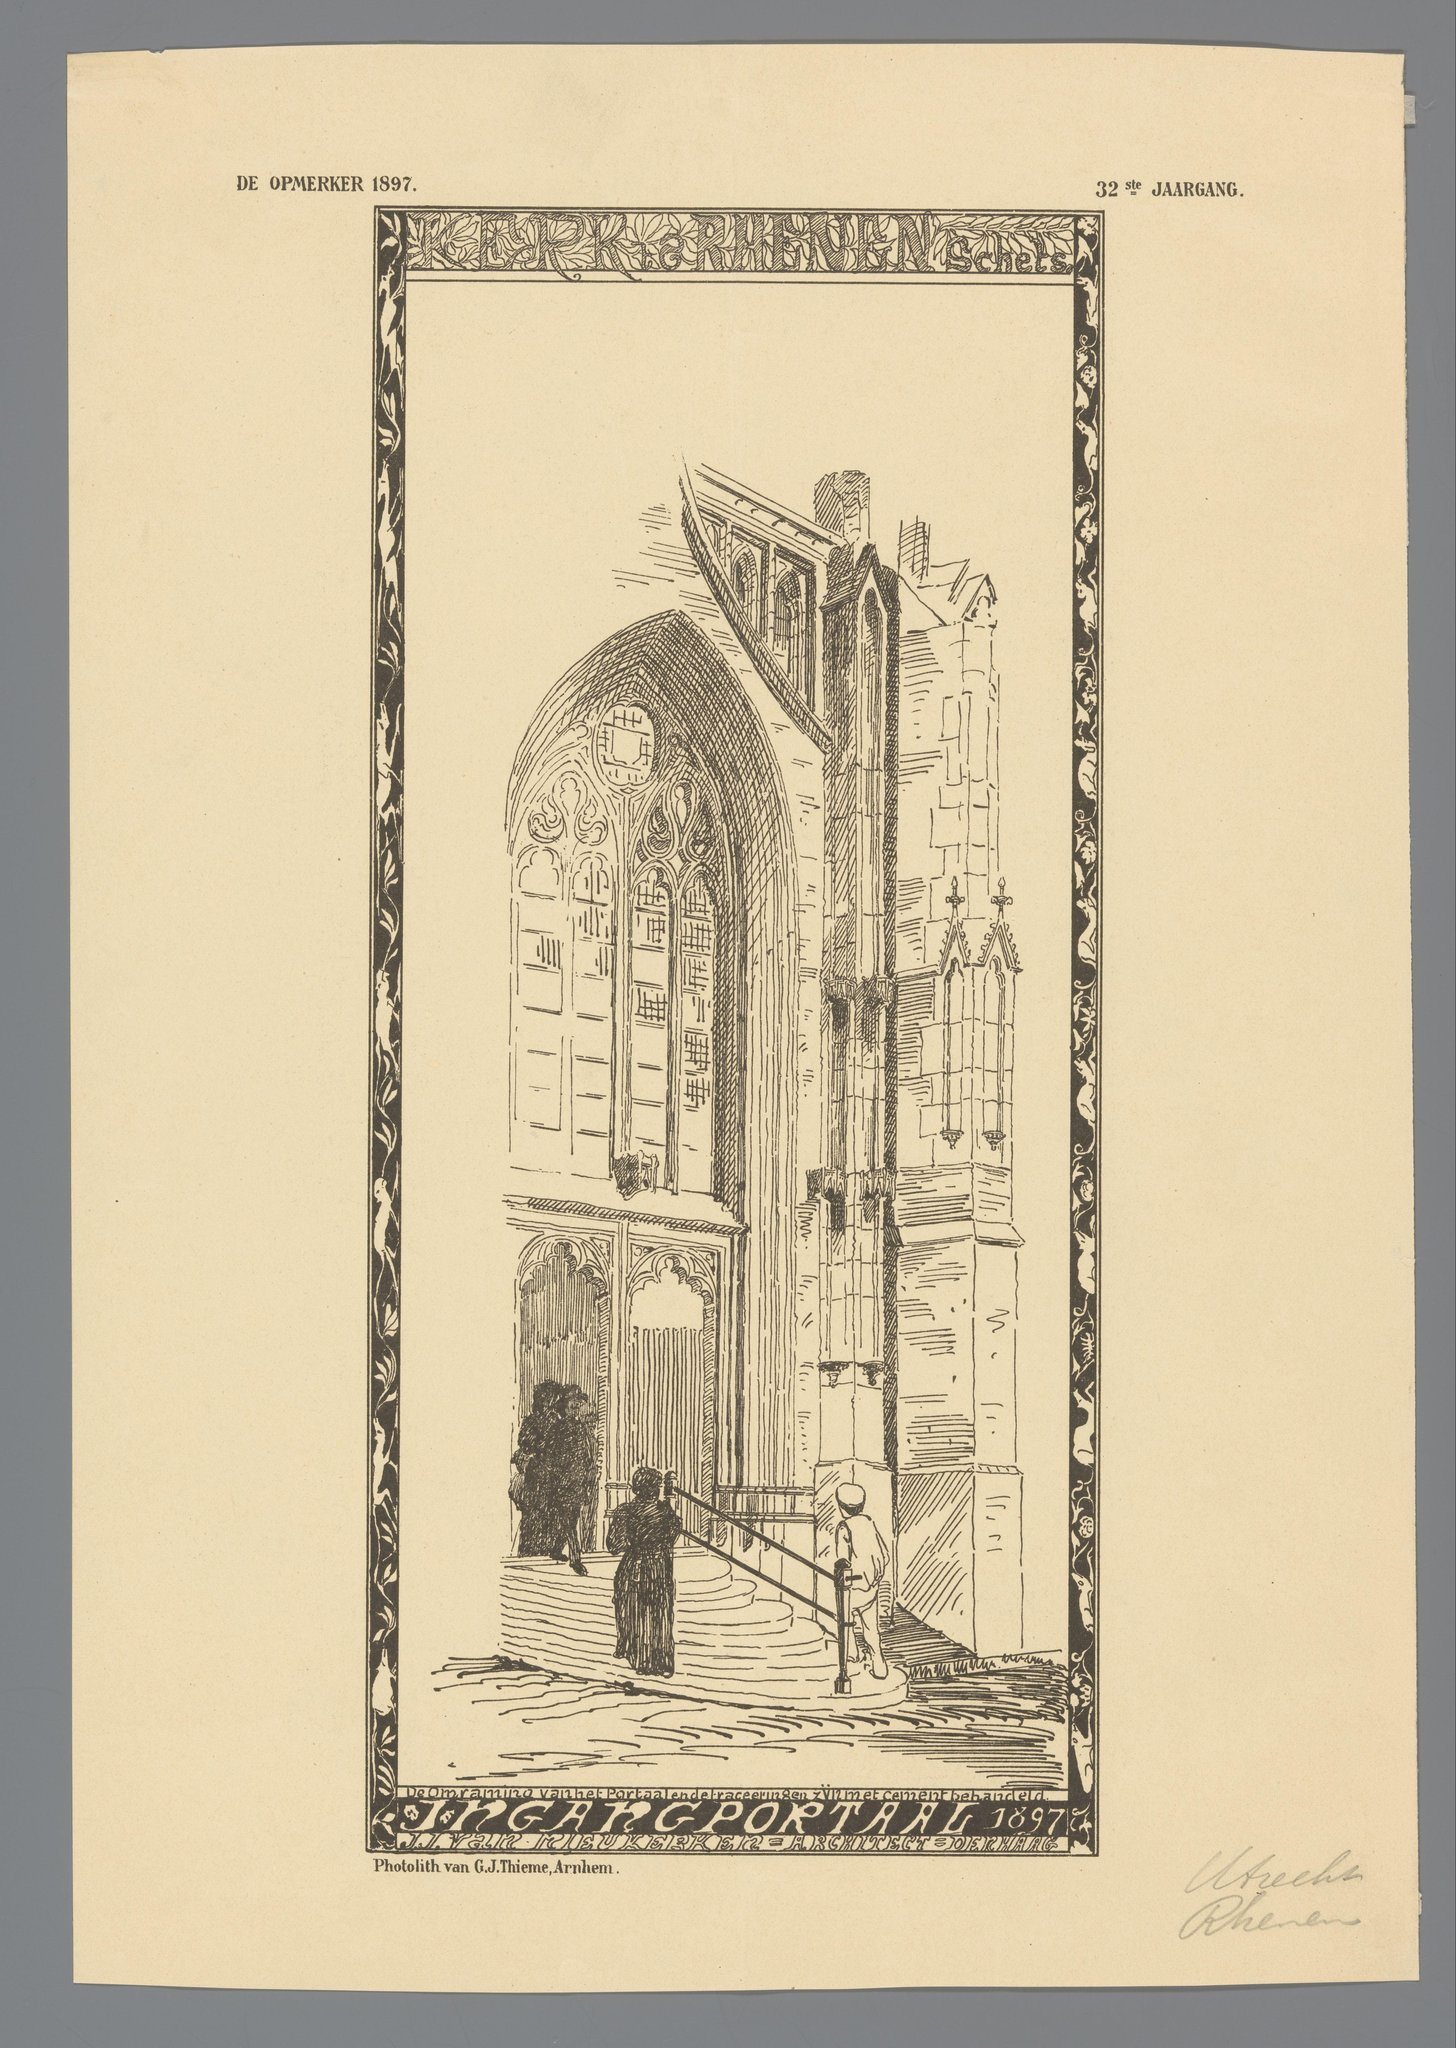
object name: photomechanical print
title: Gezicht op de Cunerakerk in Rhenen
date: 1897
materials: paper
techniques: photolithography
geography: arnhem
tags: church (exterior)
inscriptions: date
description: Prent uit: De Opmerker 32 (1897), nr. 42, 16 oktober 1897, p. 336-337.